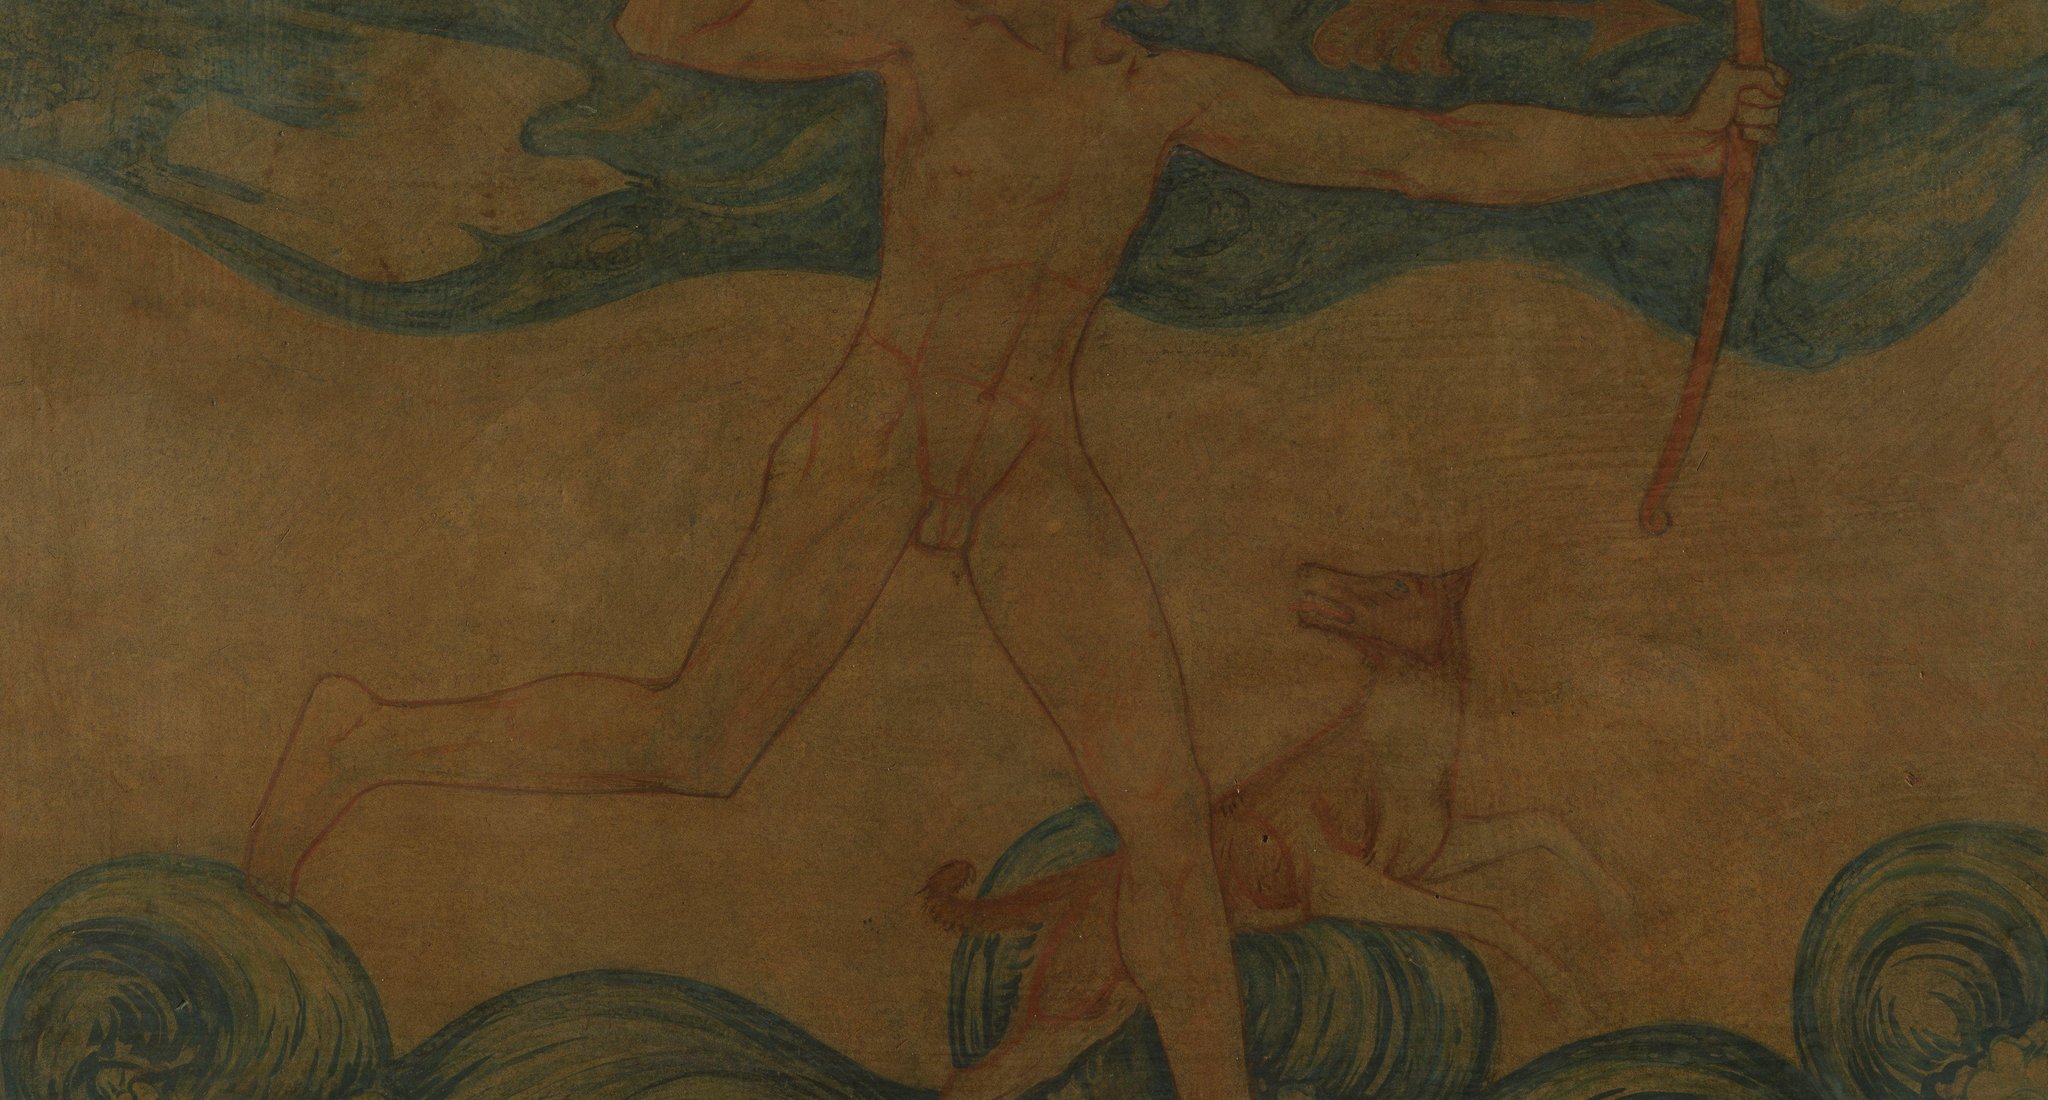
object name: painting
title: Expectation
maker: richard nicolaüs roland holst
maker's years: 1868-1938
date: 1913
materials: asbestos, asbestos cement, paint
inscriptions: signature and date: ‘[monogram] 13’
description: Verwachting. Allegorische voorstelling met een naakte man die rennend een pijl met boog afschiet, aan zijn voeten een hond. Op de achtergrond gestileerde golven en vogels in de lucht. Wandschildering gemaakt voor een interieur van Berlage dat tentoongesteld werd op de Bouwkunst tentoonstelling te Leipzig in 1913.